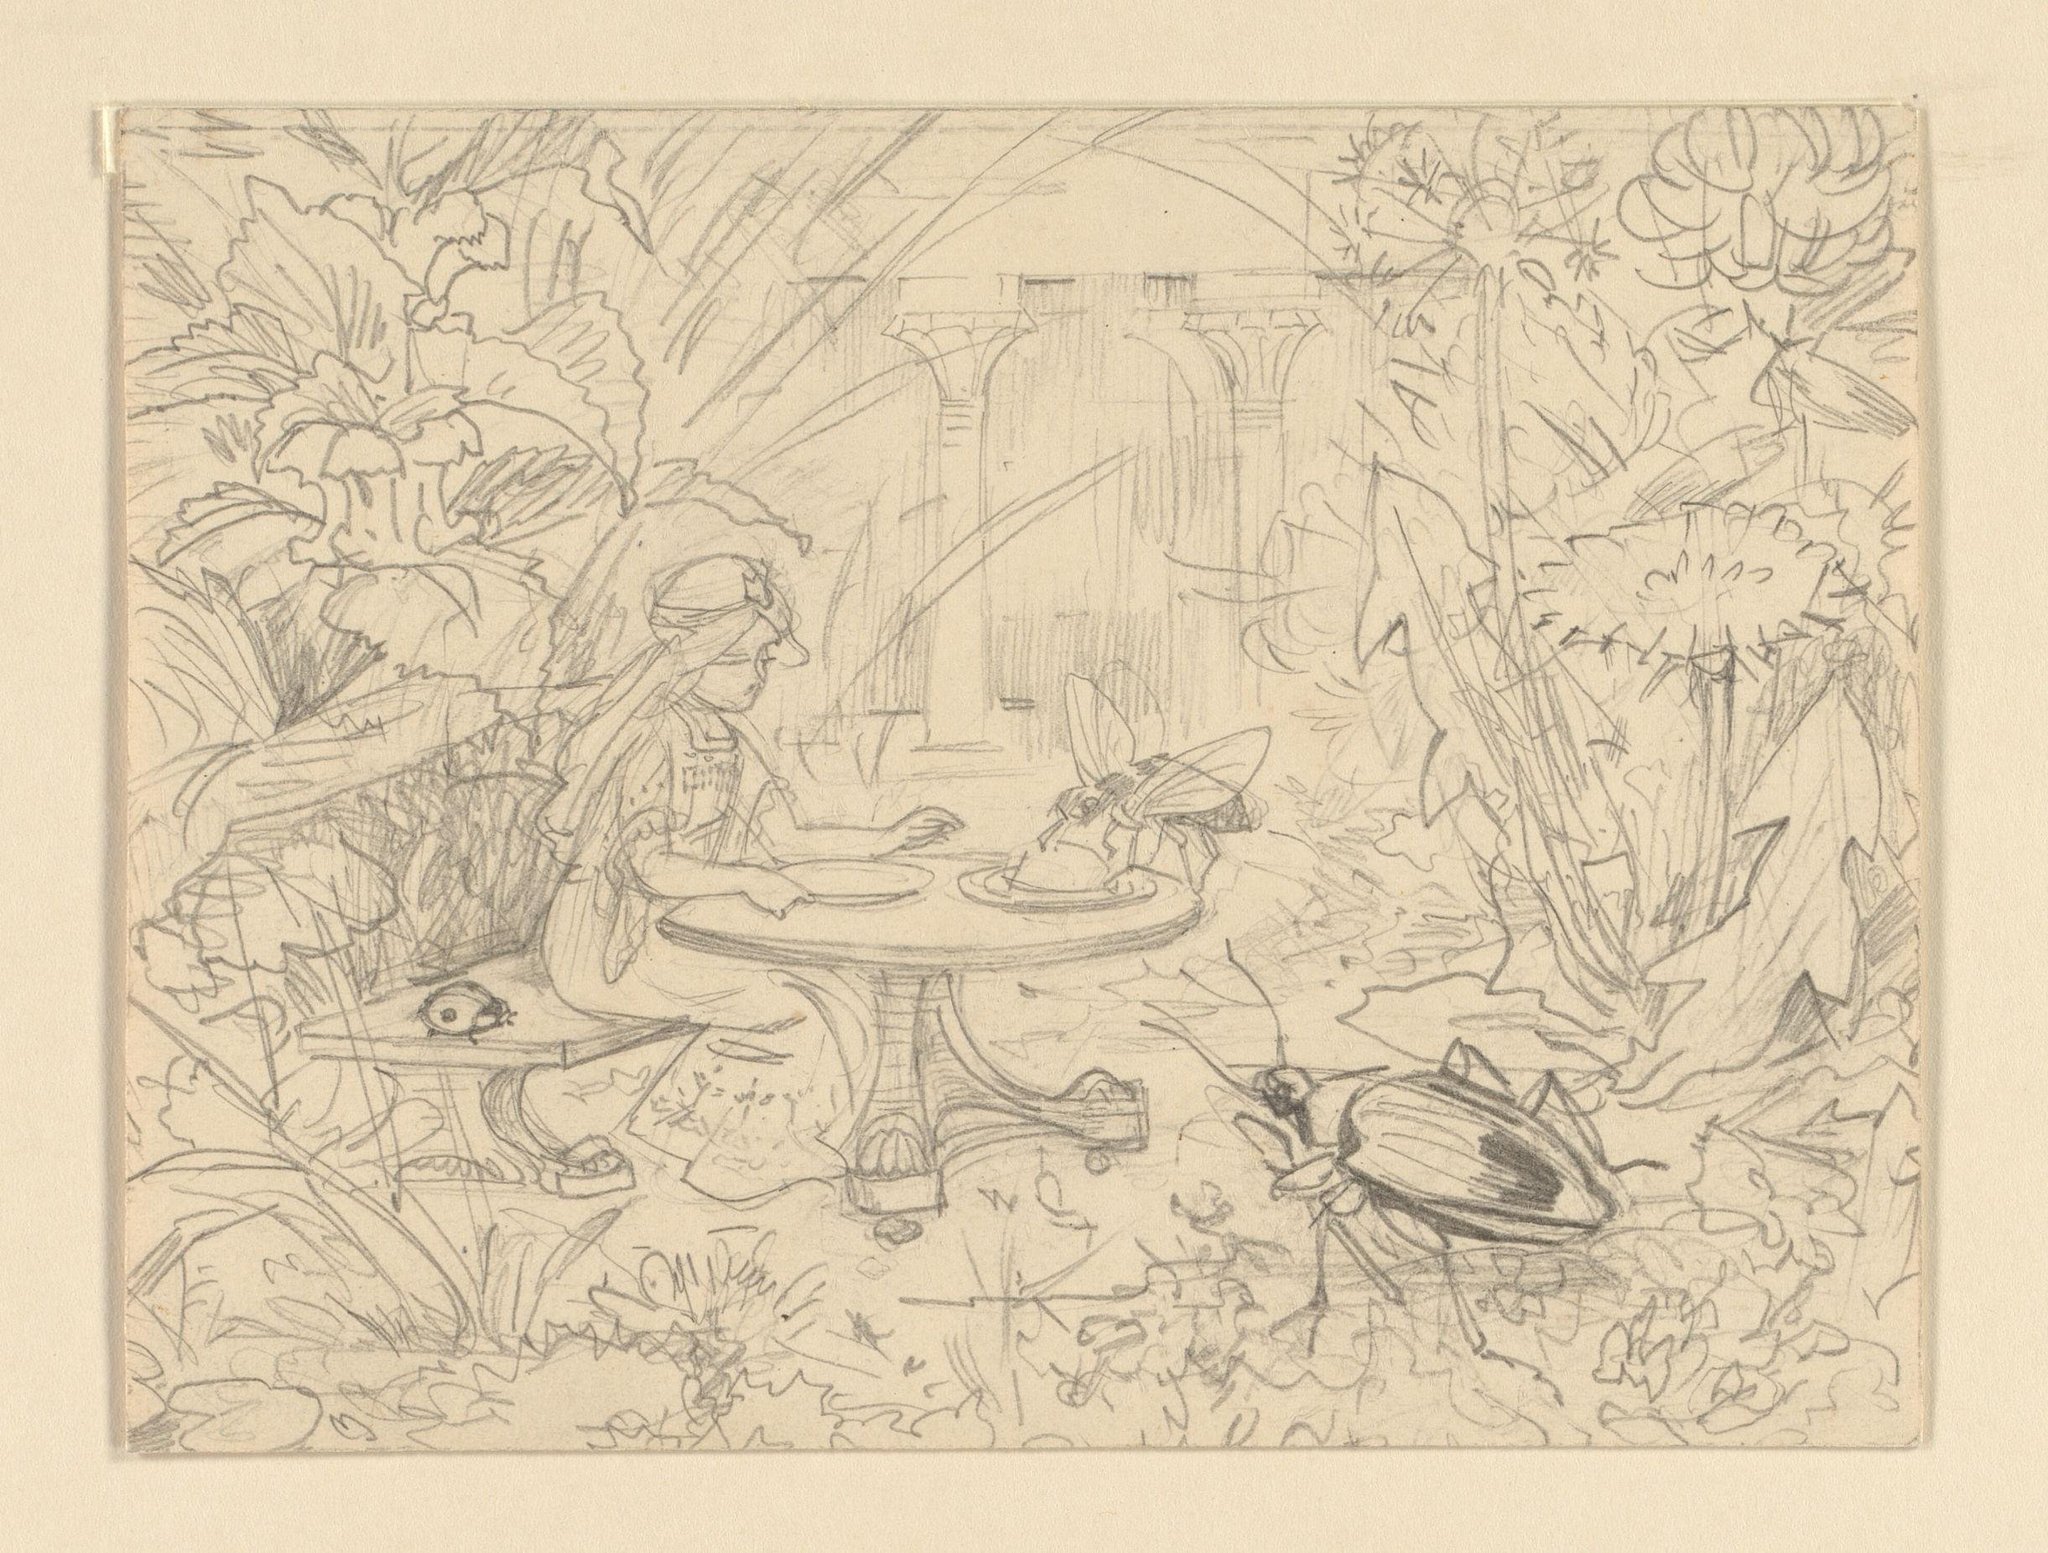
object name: drawing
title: De Grasprinses aan een tafel met insecten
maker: edzard koning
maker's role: draughtsman, print maker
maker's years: 1869-1954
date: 1903-1931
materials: cardboard, pencil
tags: flowers, (koning, de grasprinses) specific works of literature (with author, title), princess, tales and fairy tales, insects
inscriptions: number: ‘4.’, collector's mark: Lugt 2228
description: Ontwerp voor het niet uitgegeven sprookje: Koning, Edzard. De Grasprinses. Bussum: C.A.J. van Dishoeck, s.a.